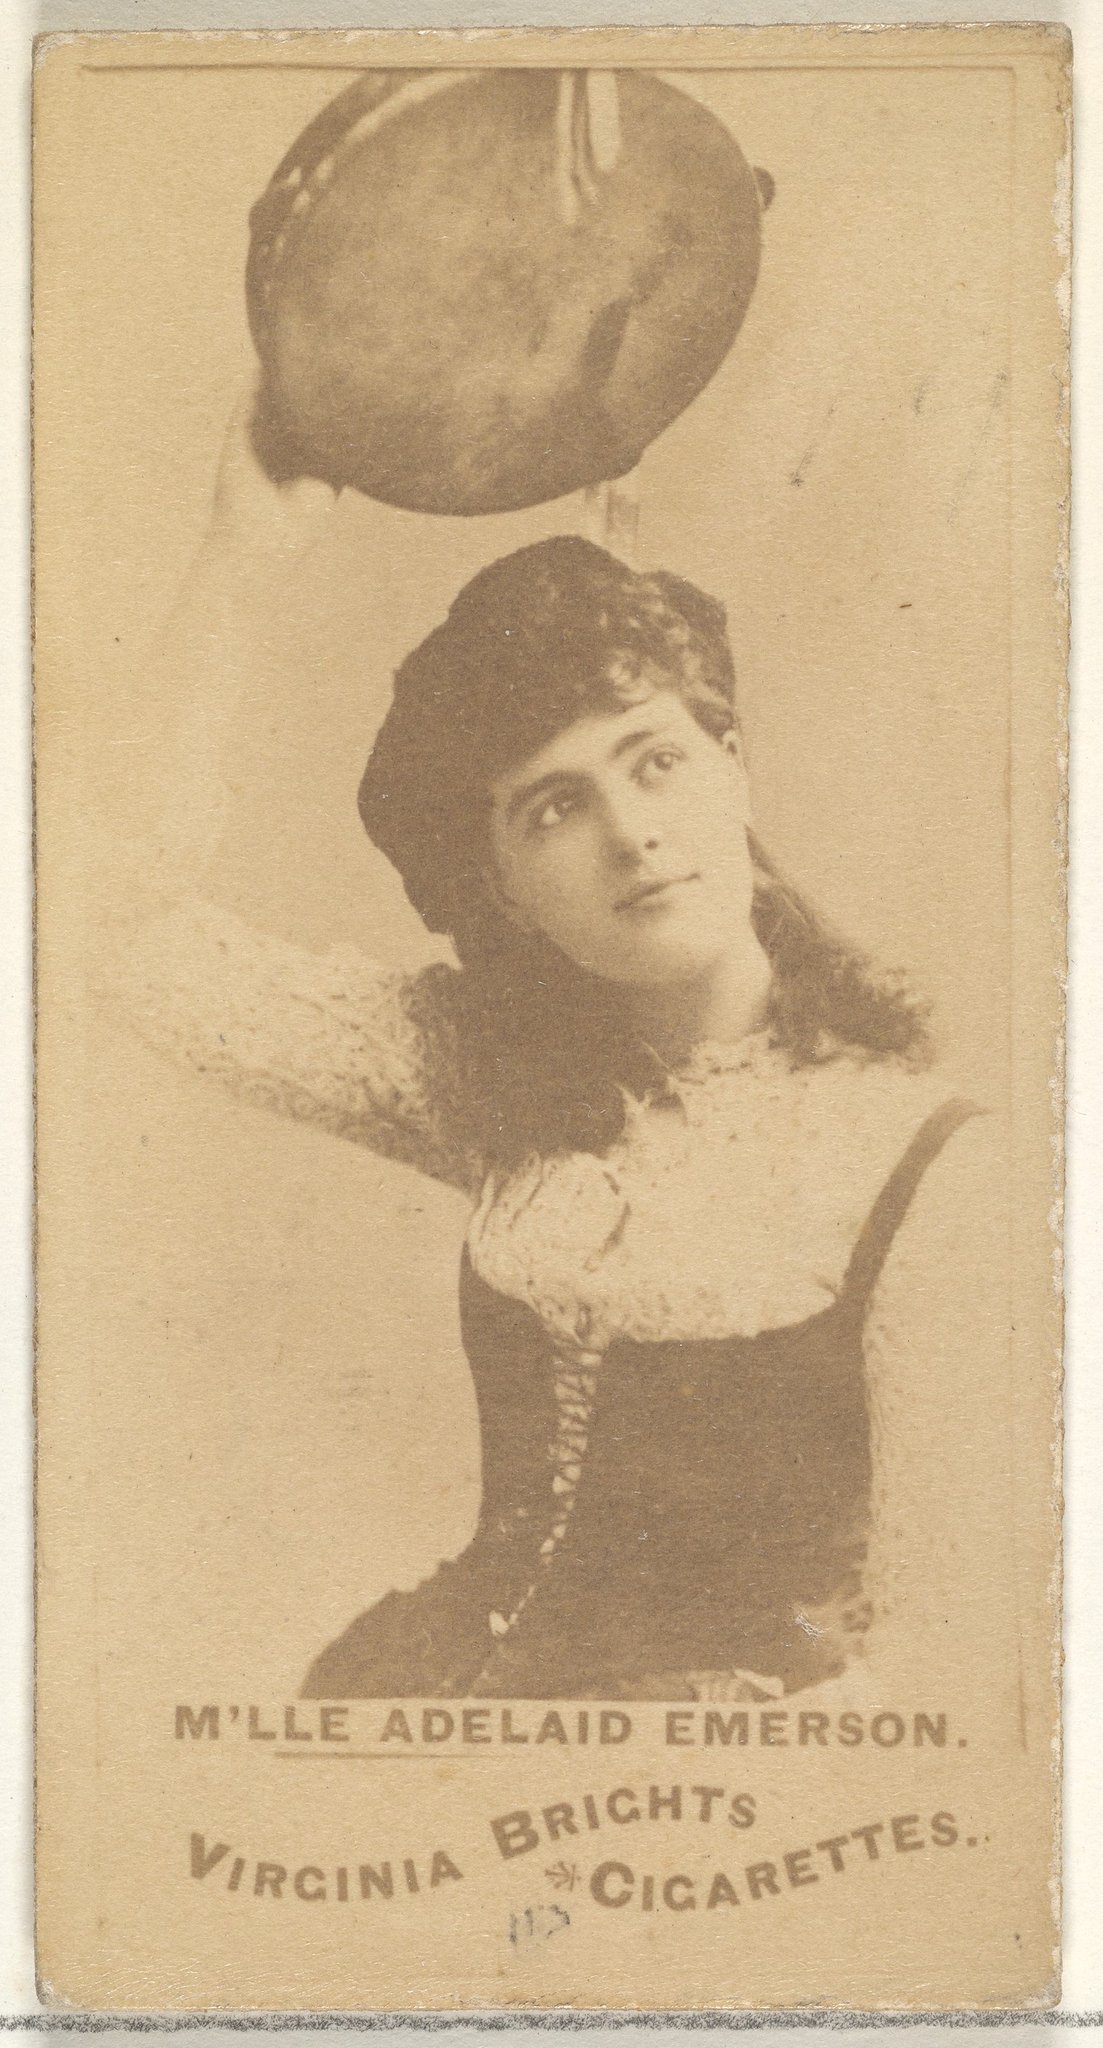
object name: photograph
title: Mlle. Adelaid Emerson, from the Actors and Actresses series (N45, Type 1) for Virginia Brights Cigarettes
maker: allen & ginter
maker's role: publisher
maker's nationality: american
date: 1888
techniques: albumen silver print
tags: musical instruments,portraits,women,actresses